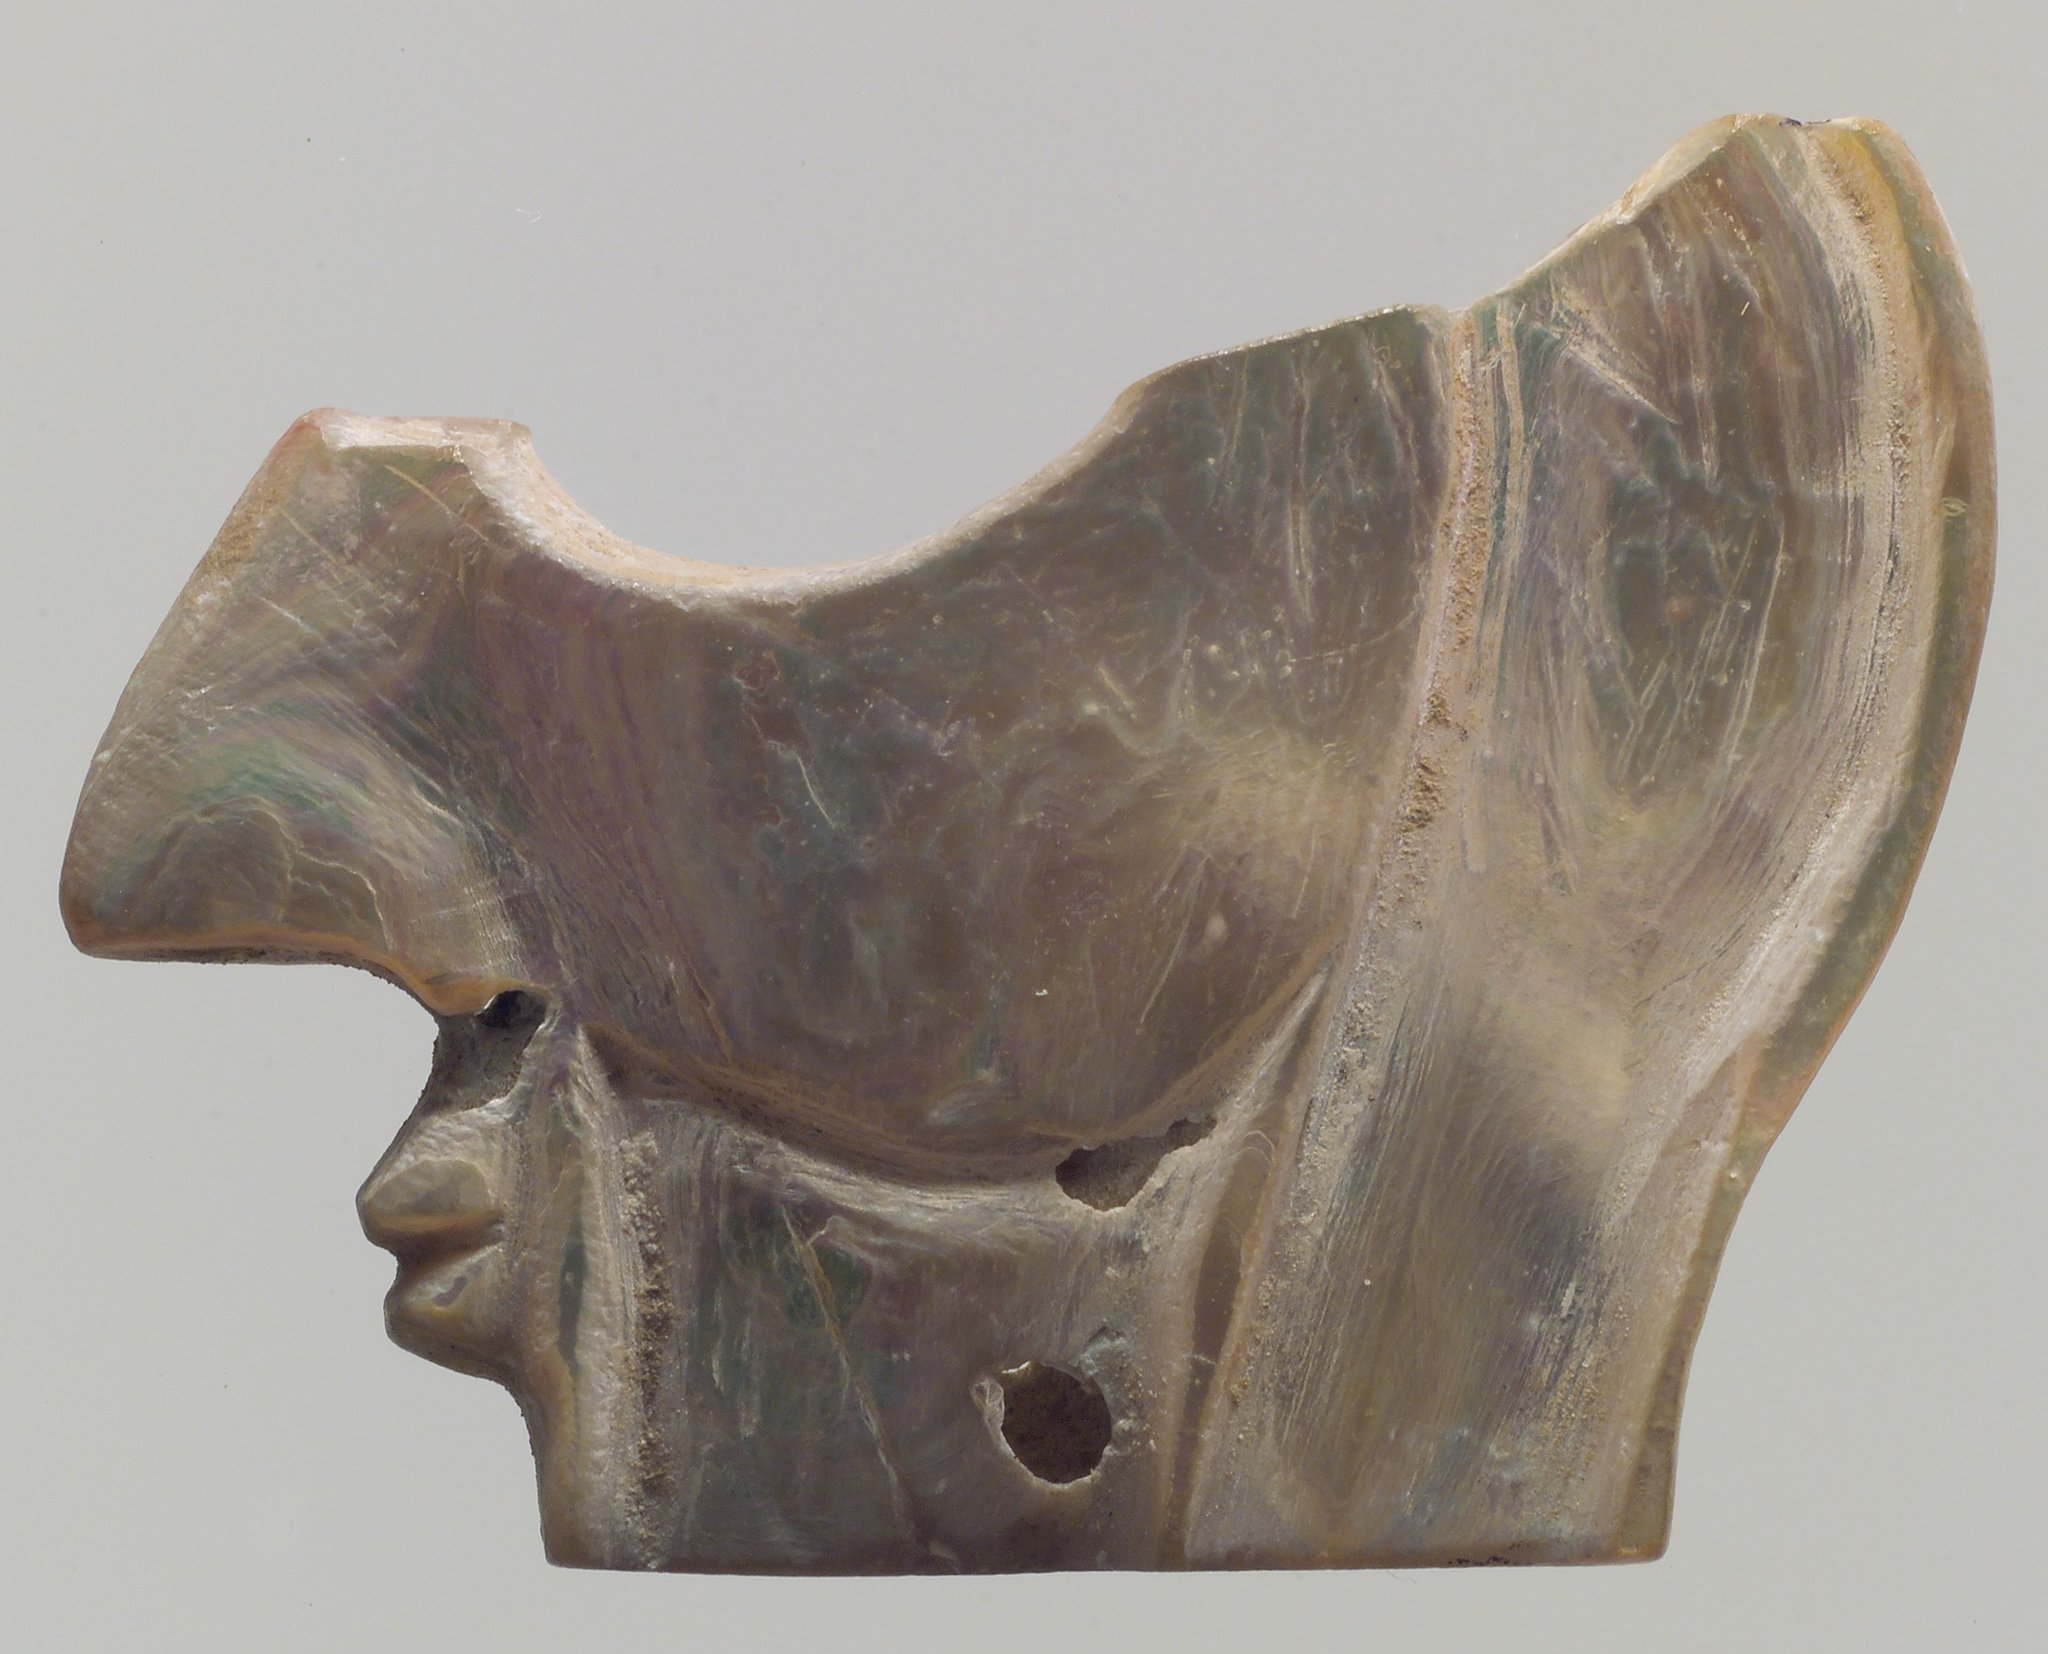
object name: inlay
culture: sumerian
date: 2600-2350 BCE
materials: shell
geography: mesopotamia